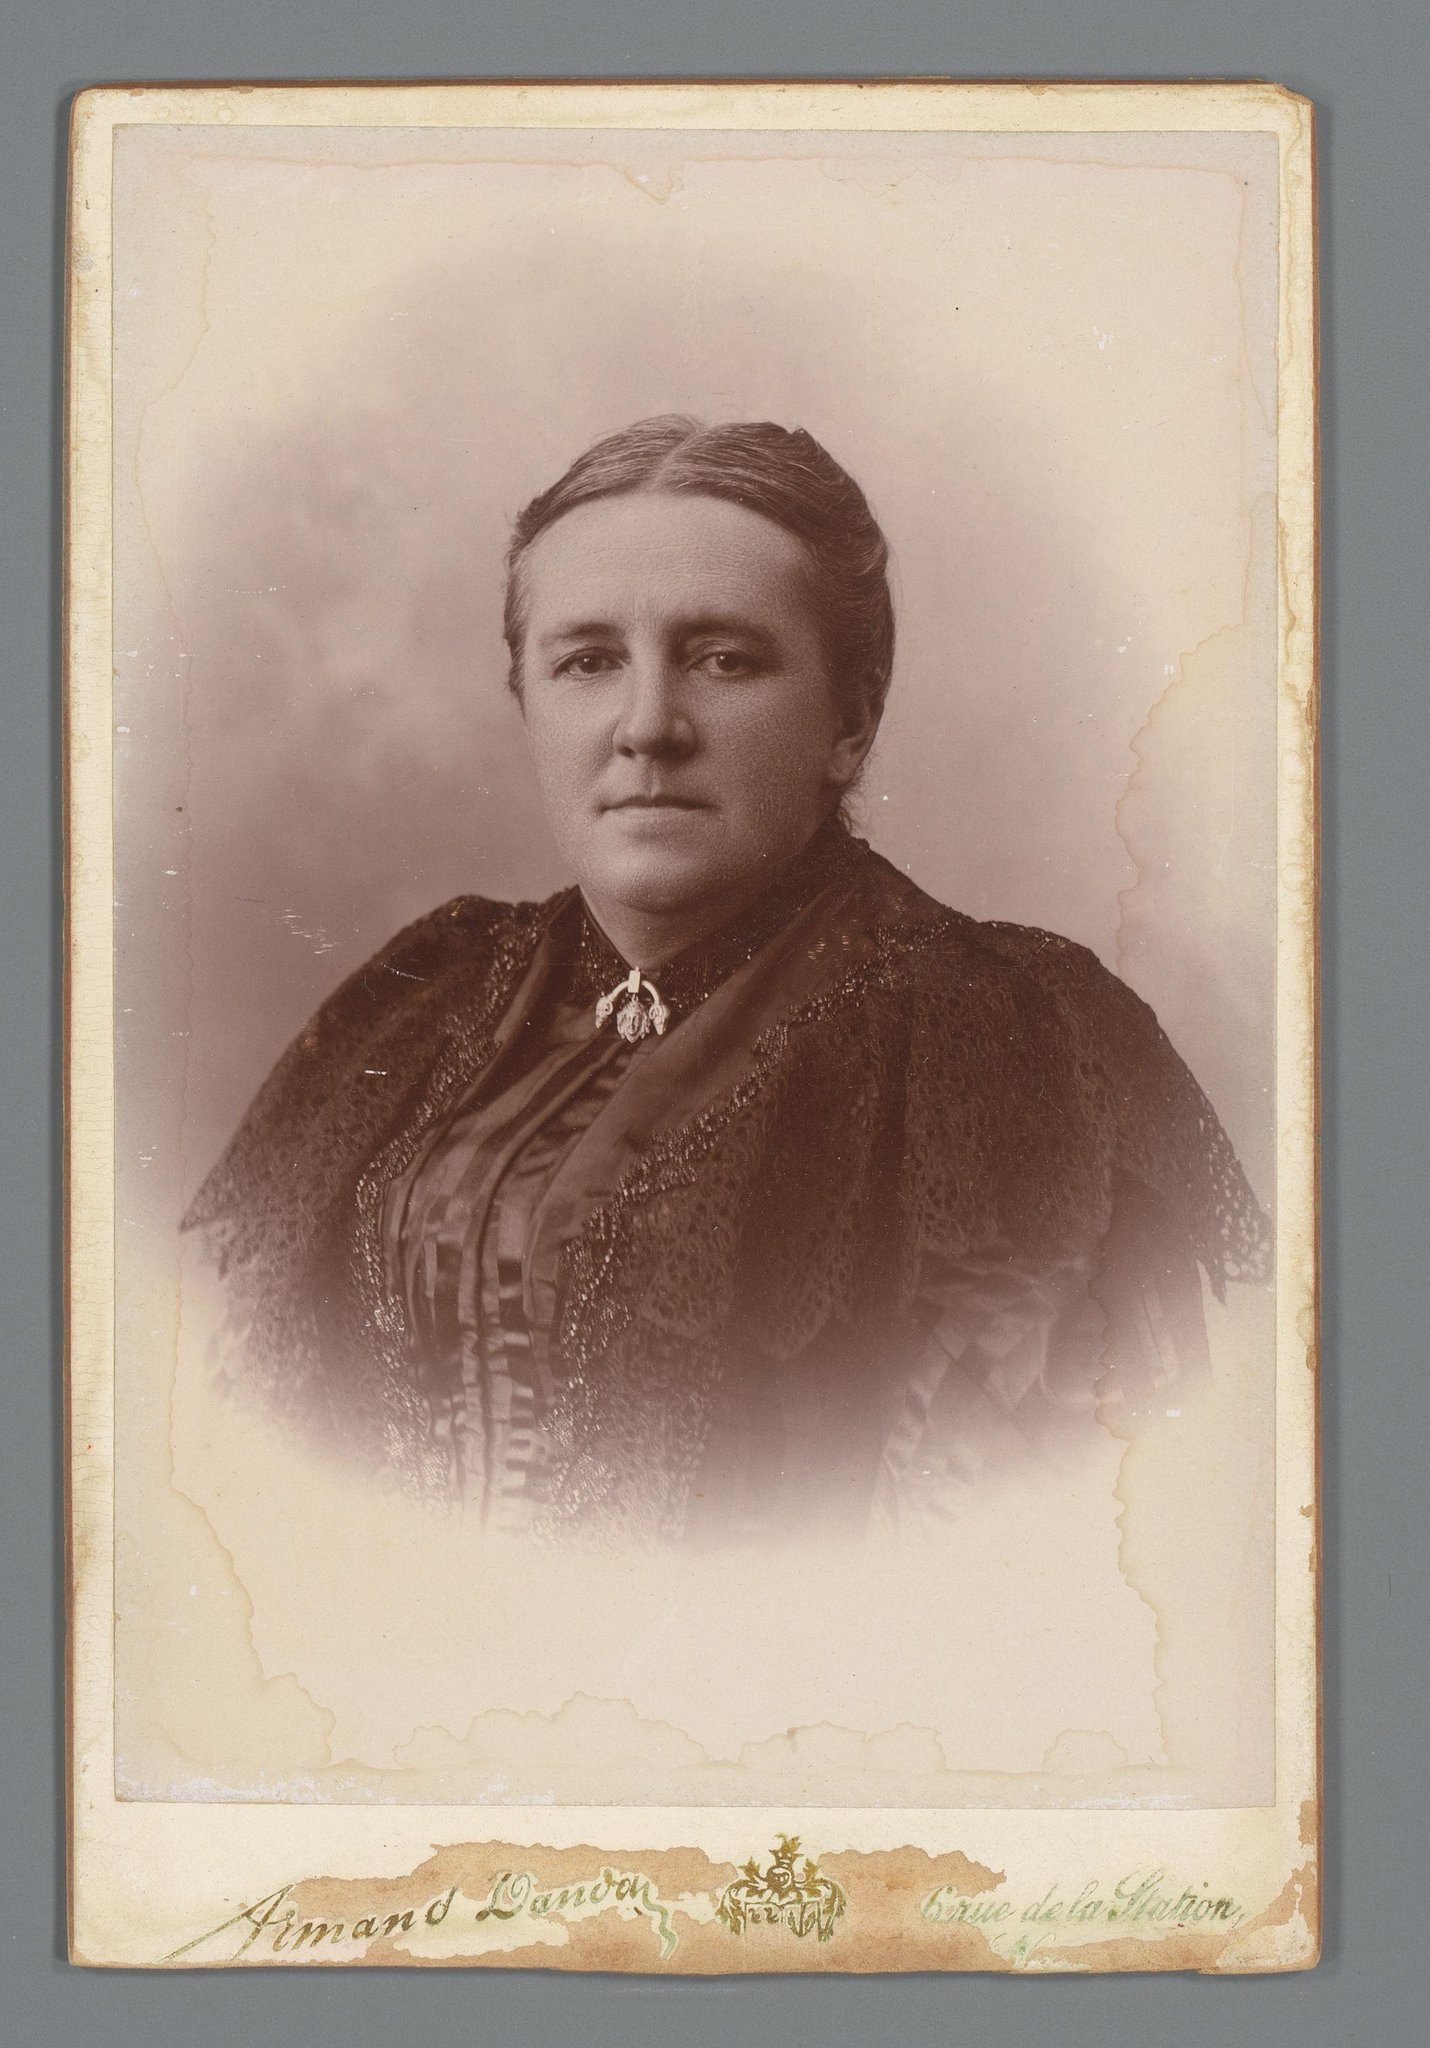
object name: cabinet photograph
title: Portret van een onbekende vrouw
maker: armand dandoy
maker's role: painter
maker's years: 1834-1898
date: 1880-1898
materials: paper, cardboard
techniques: collodion silver print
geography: namur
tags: adult woman, anonymous historical person portrayed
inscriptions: address: ‘6 rue de la Station,’